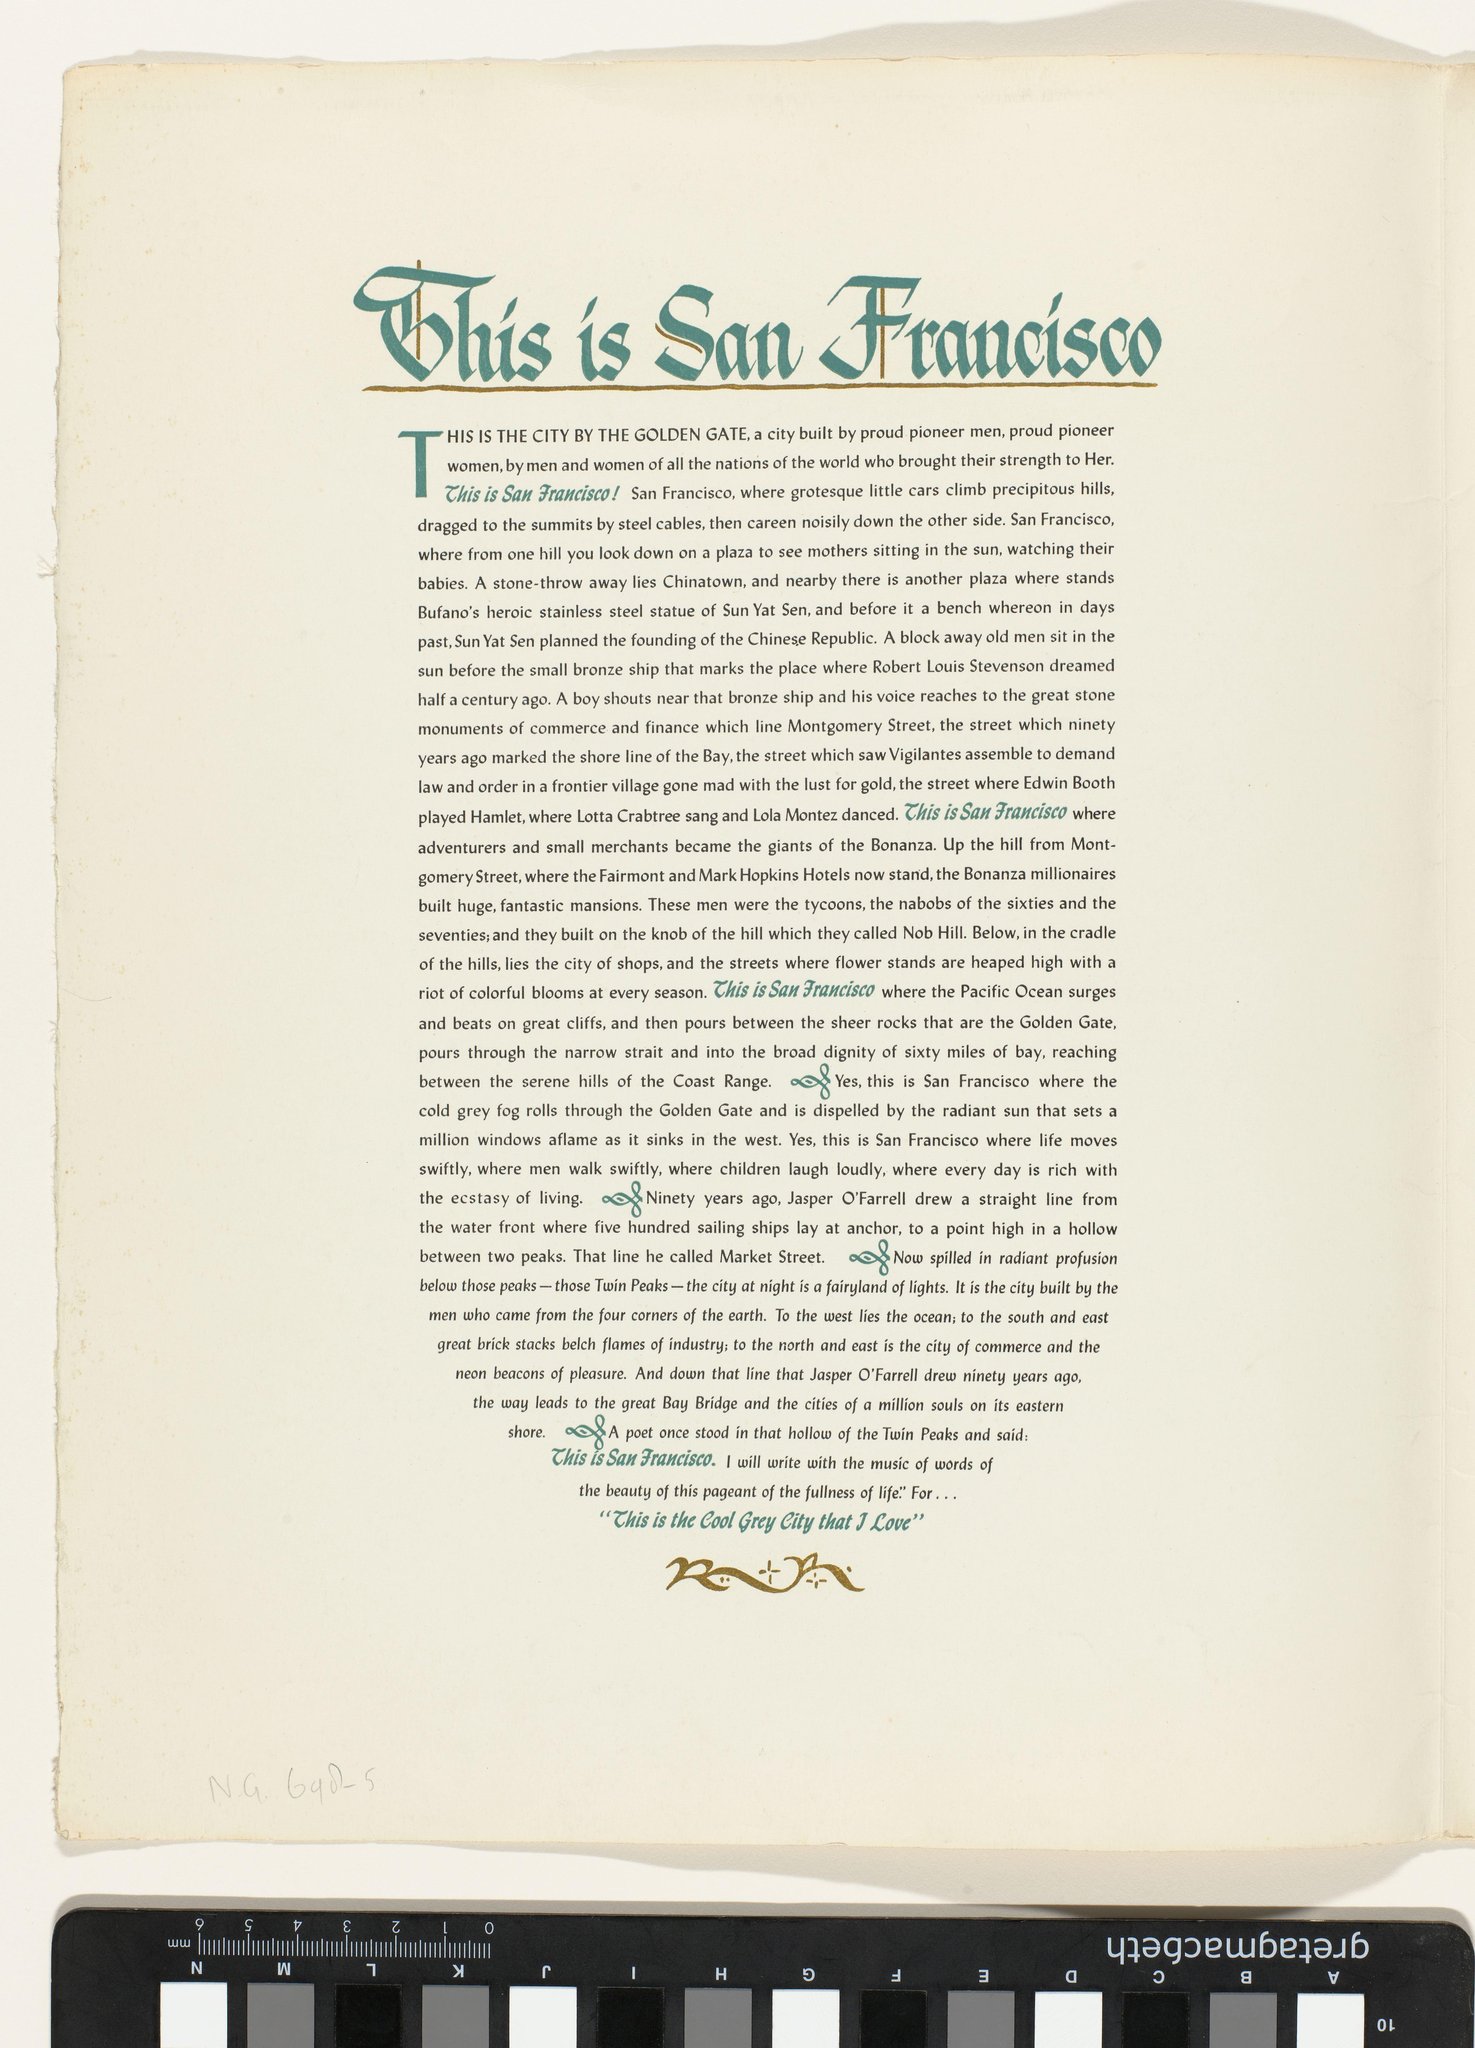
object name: photograph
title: Japanese Peace Conference: San Fransisco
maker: s. tate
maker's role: fotograaf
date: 1951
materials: paper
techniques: photography, printing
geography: san francisco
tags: san francisco, japanese peace conference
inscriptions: date: ‘4 september 1951’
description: Dubbelgevouwen blad dik papier, drie pp bedrukt, waarin los een foto van Golden Gate Bridge, San Francisco . Gemaakt ter gelegenheid van het vredesverdrag met Japan. Op de voorkant staat: A step toward Peace in the Pacific. Het verdrag werd getekend in san Fransisco.